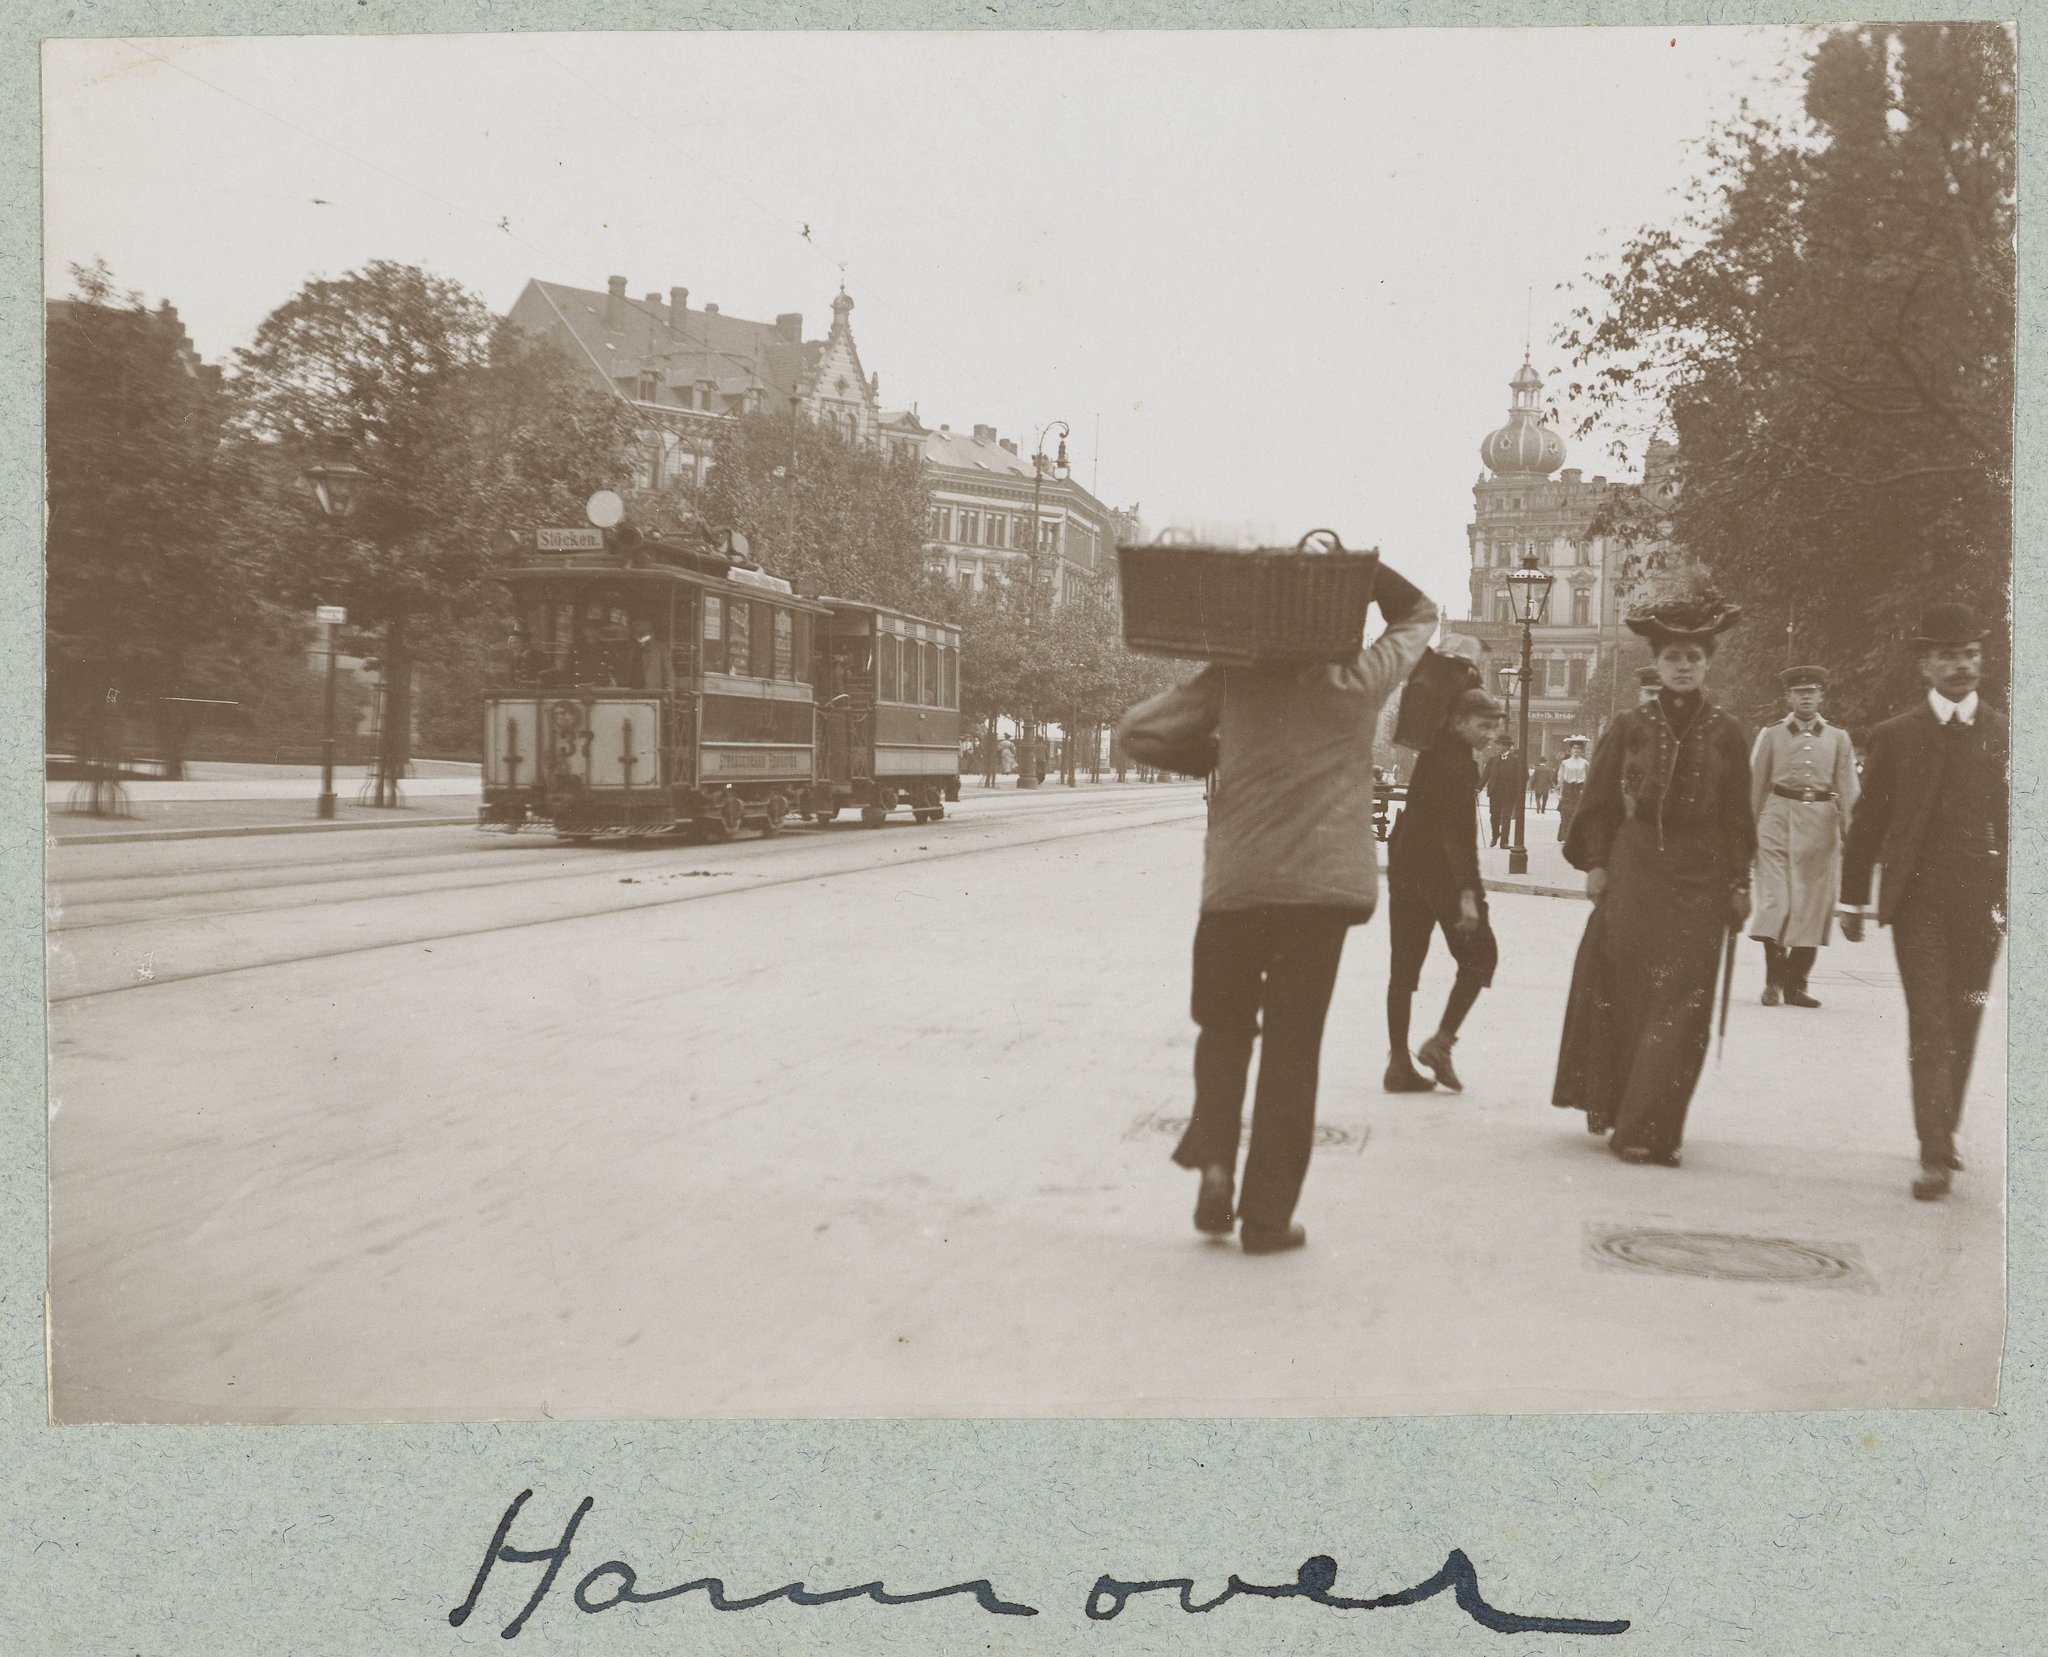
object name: photograph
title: Straatgezicht met trambaan in Hannover.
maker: frits freerks fontein fz.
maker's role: fotograaf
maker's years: 1882-1928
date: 1903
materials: cardboard, paper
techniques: gelatin silver print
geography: germany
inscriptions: caption: ‘Hannover’